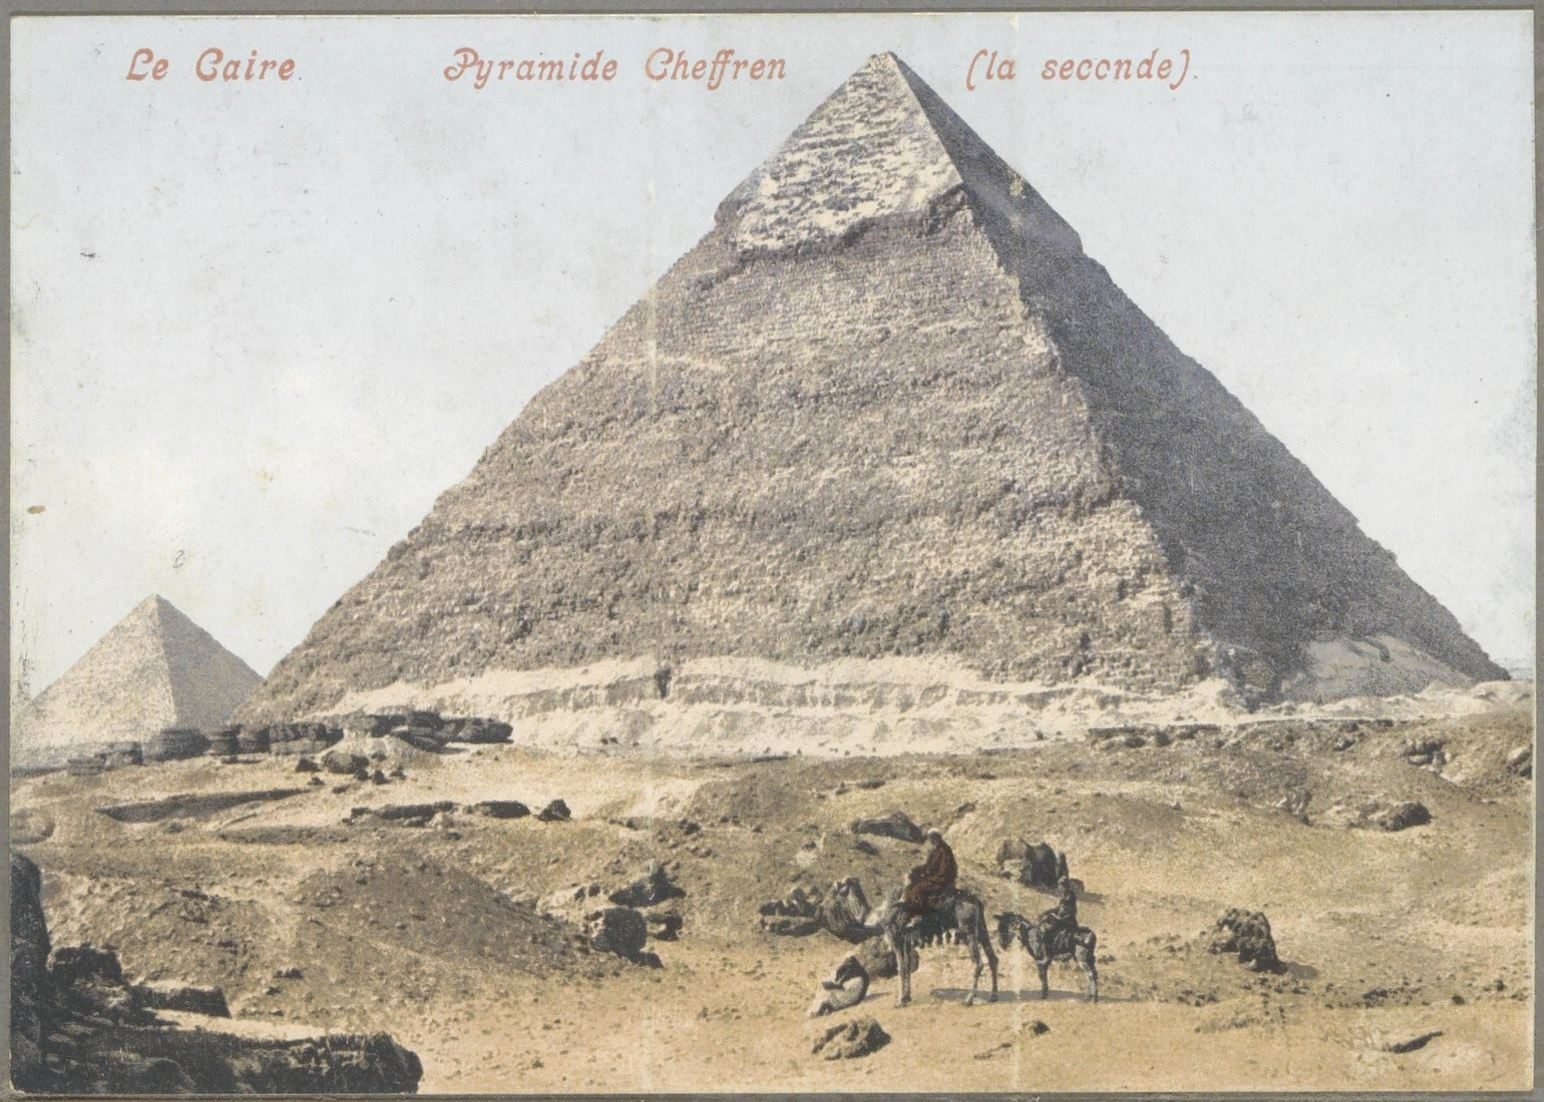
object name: album leaf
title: Le Caire Pyramide Cheffren (la seconde)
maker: Anonymous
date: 1895-1905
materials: paper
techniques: photolithography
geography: gizeh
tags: pyramid (historical grave form)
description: Onderdeel van Reisalbum met foto's van bezienswaardigheden in Griekenland en Egypte.